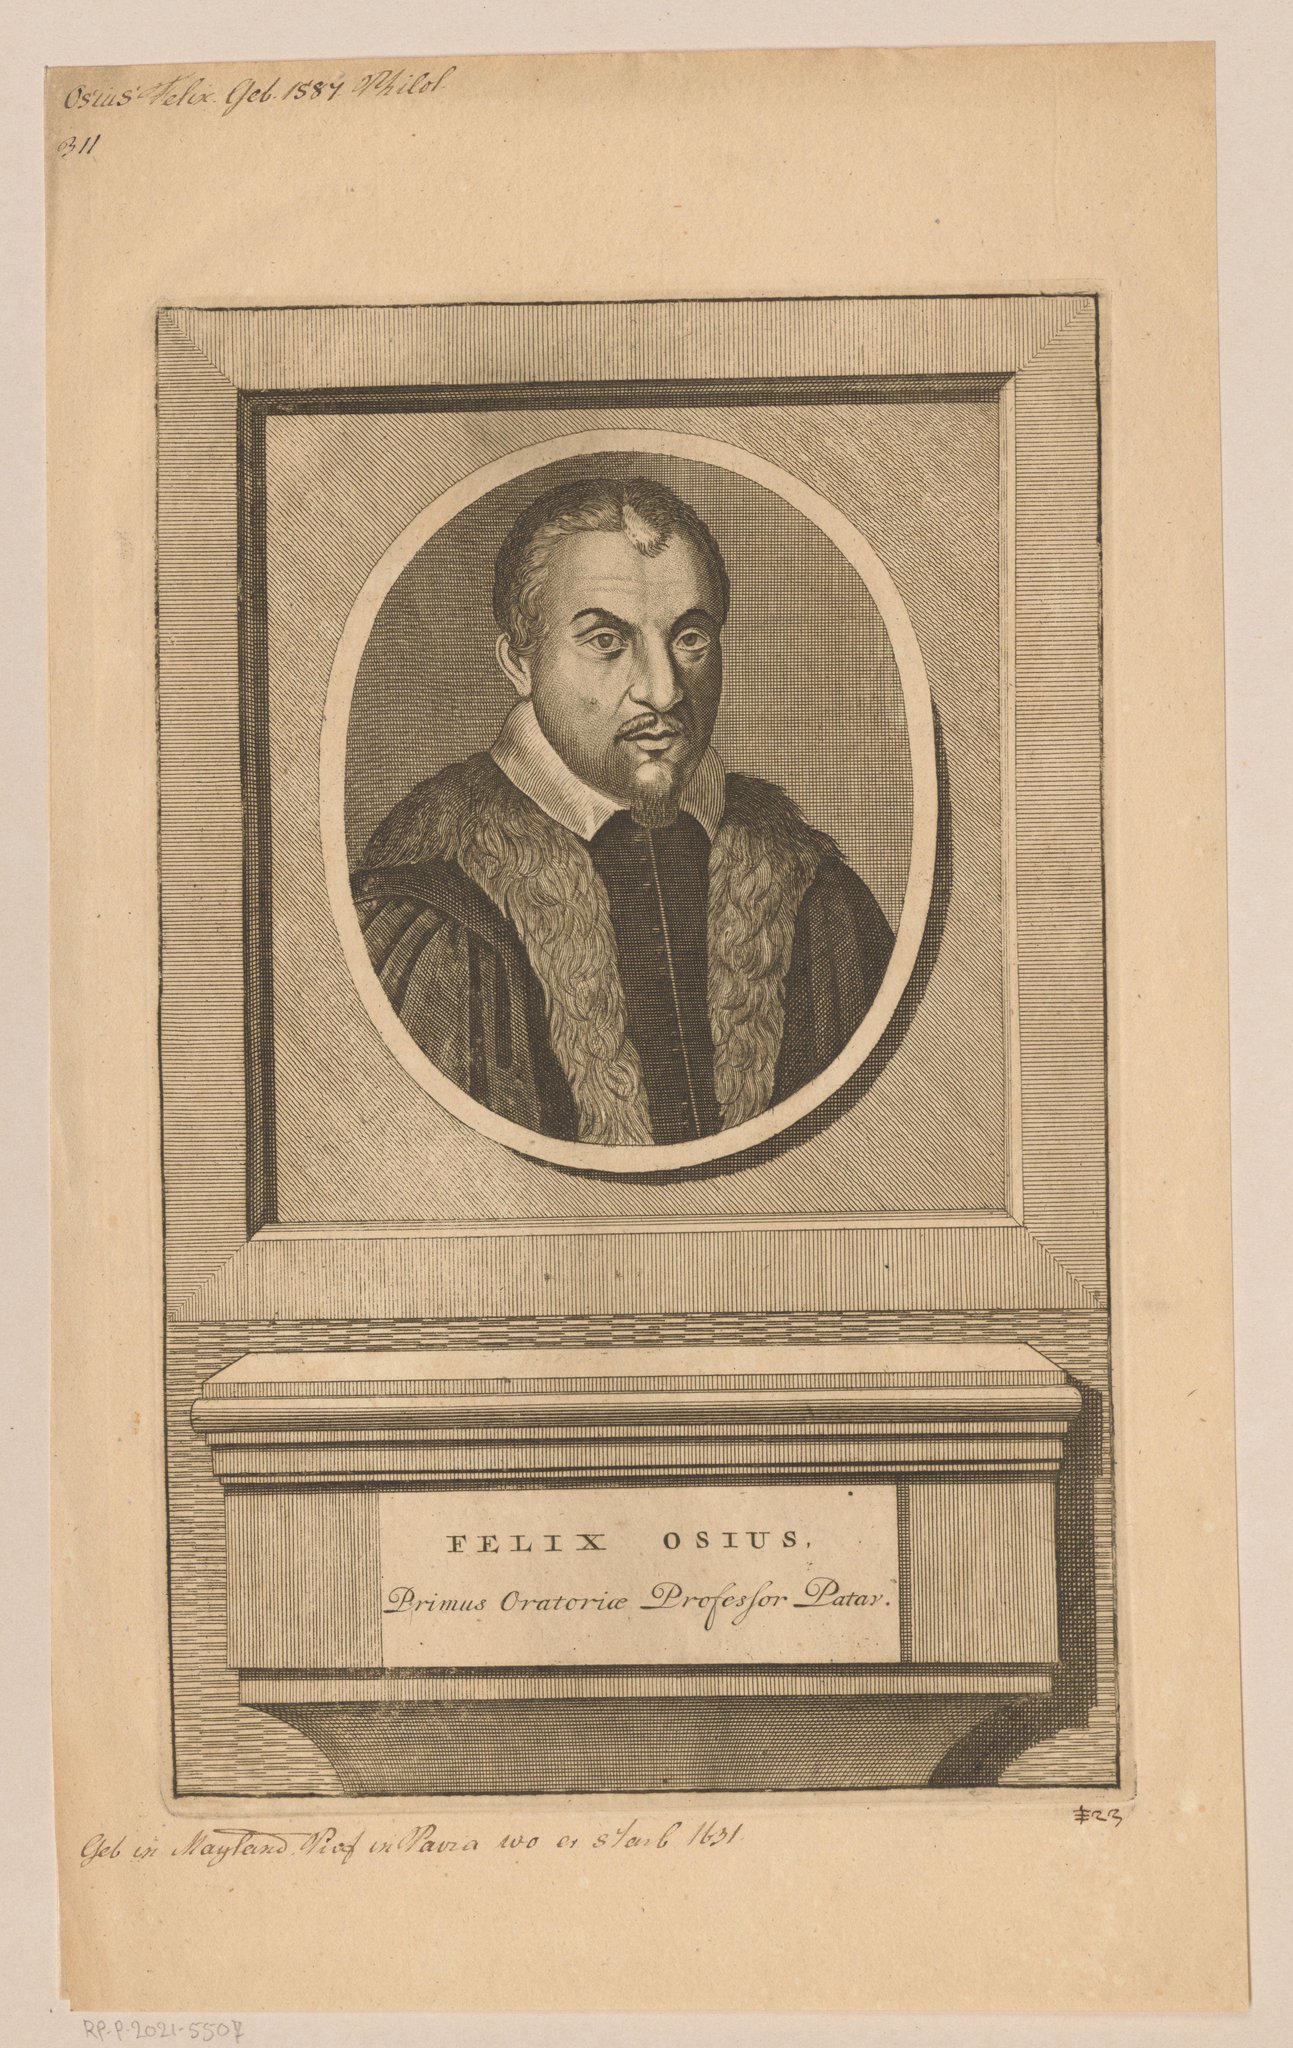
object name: print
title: Portret van Felix Osius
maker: Anonymous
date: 1700-1749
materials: paper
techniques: engraving, etching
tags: historical persons